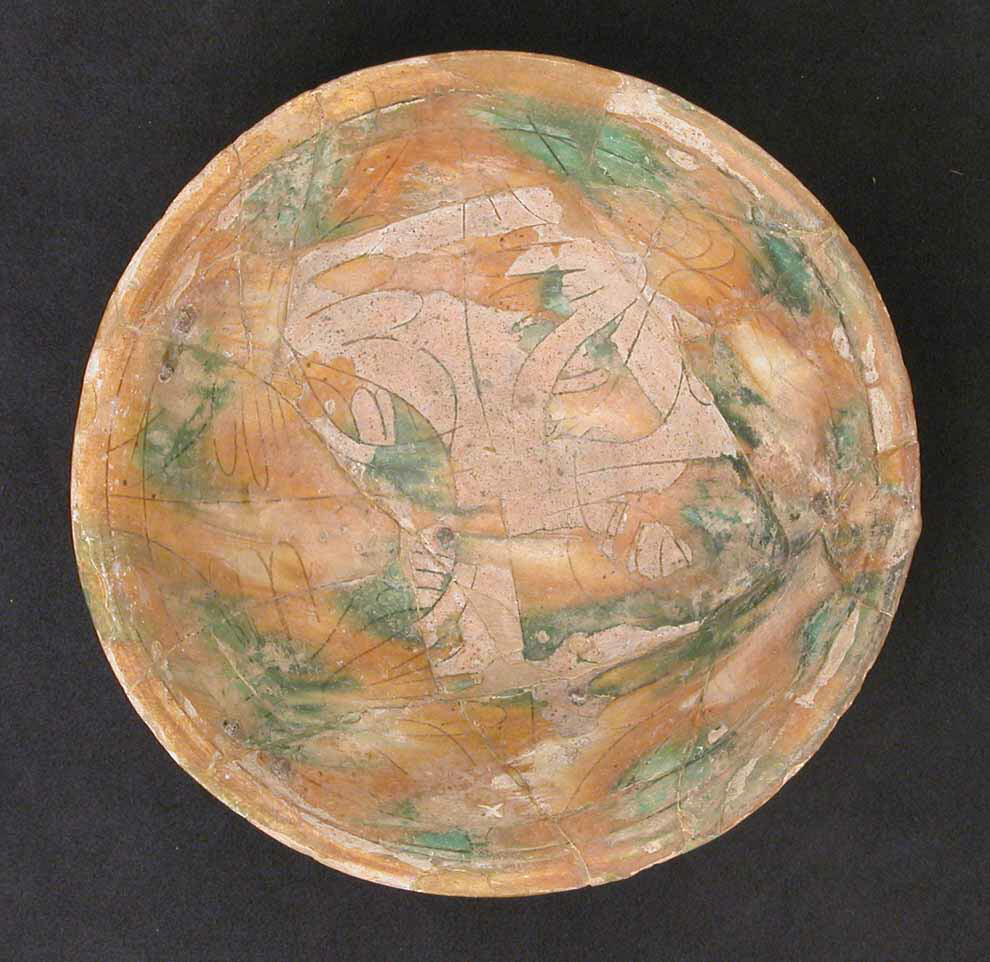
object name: bowl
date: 801-1000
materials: earthenware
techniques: glazing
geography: iran